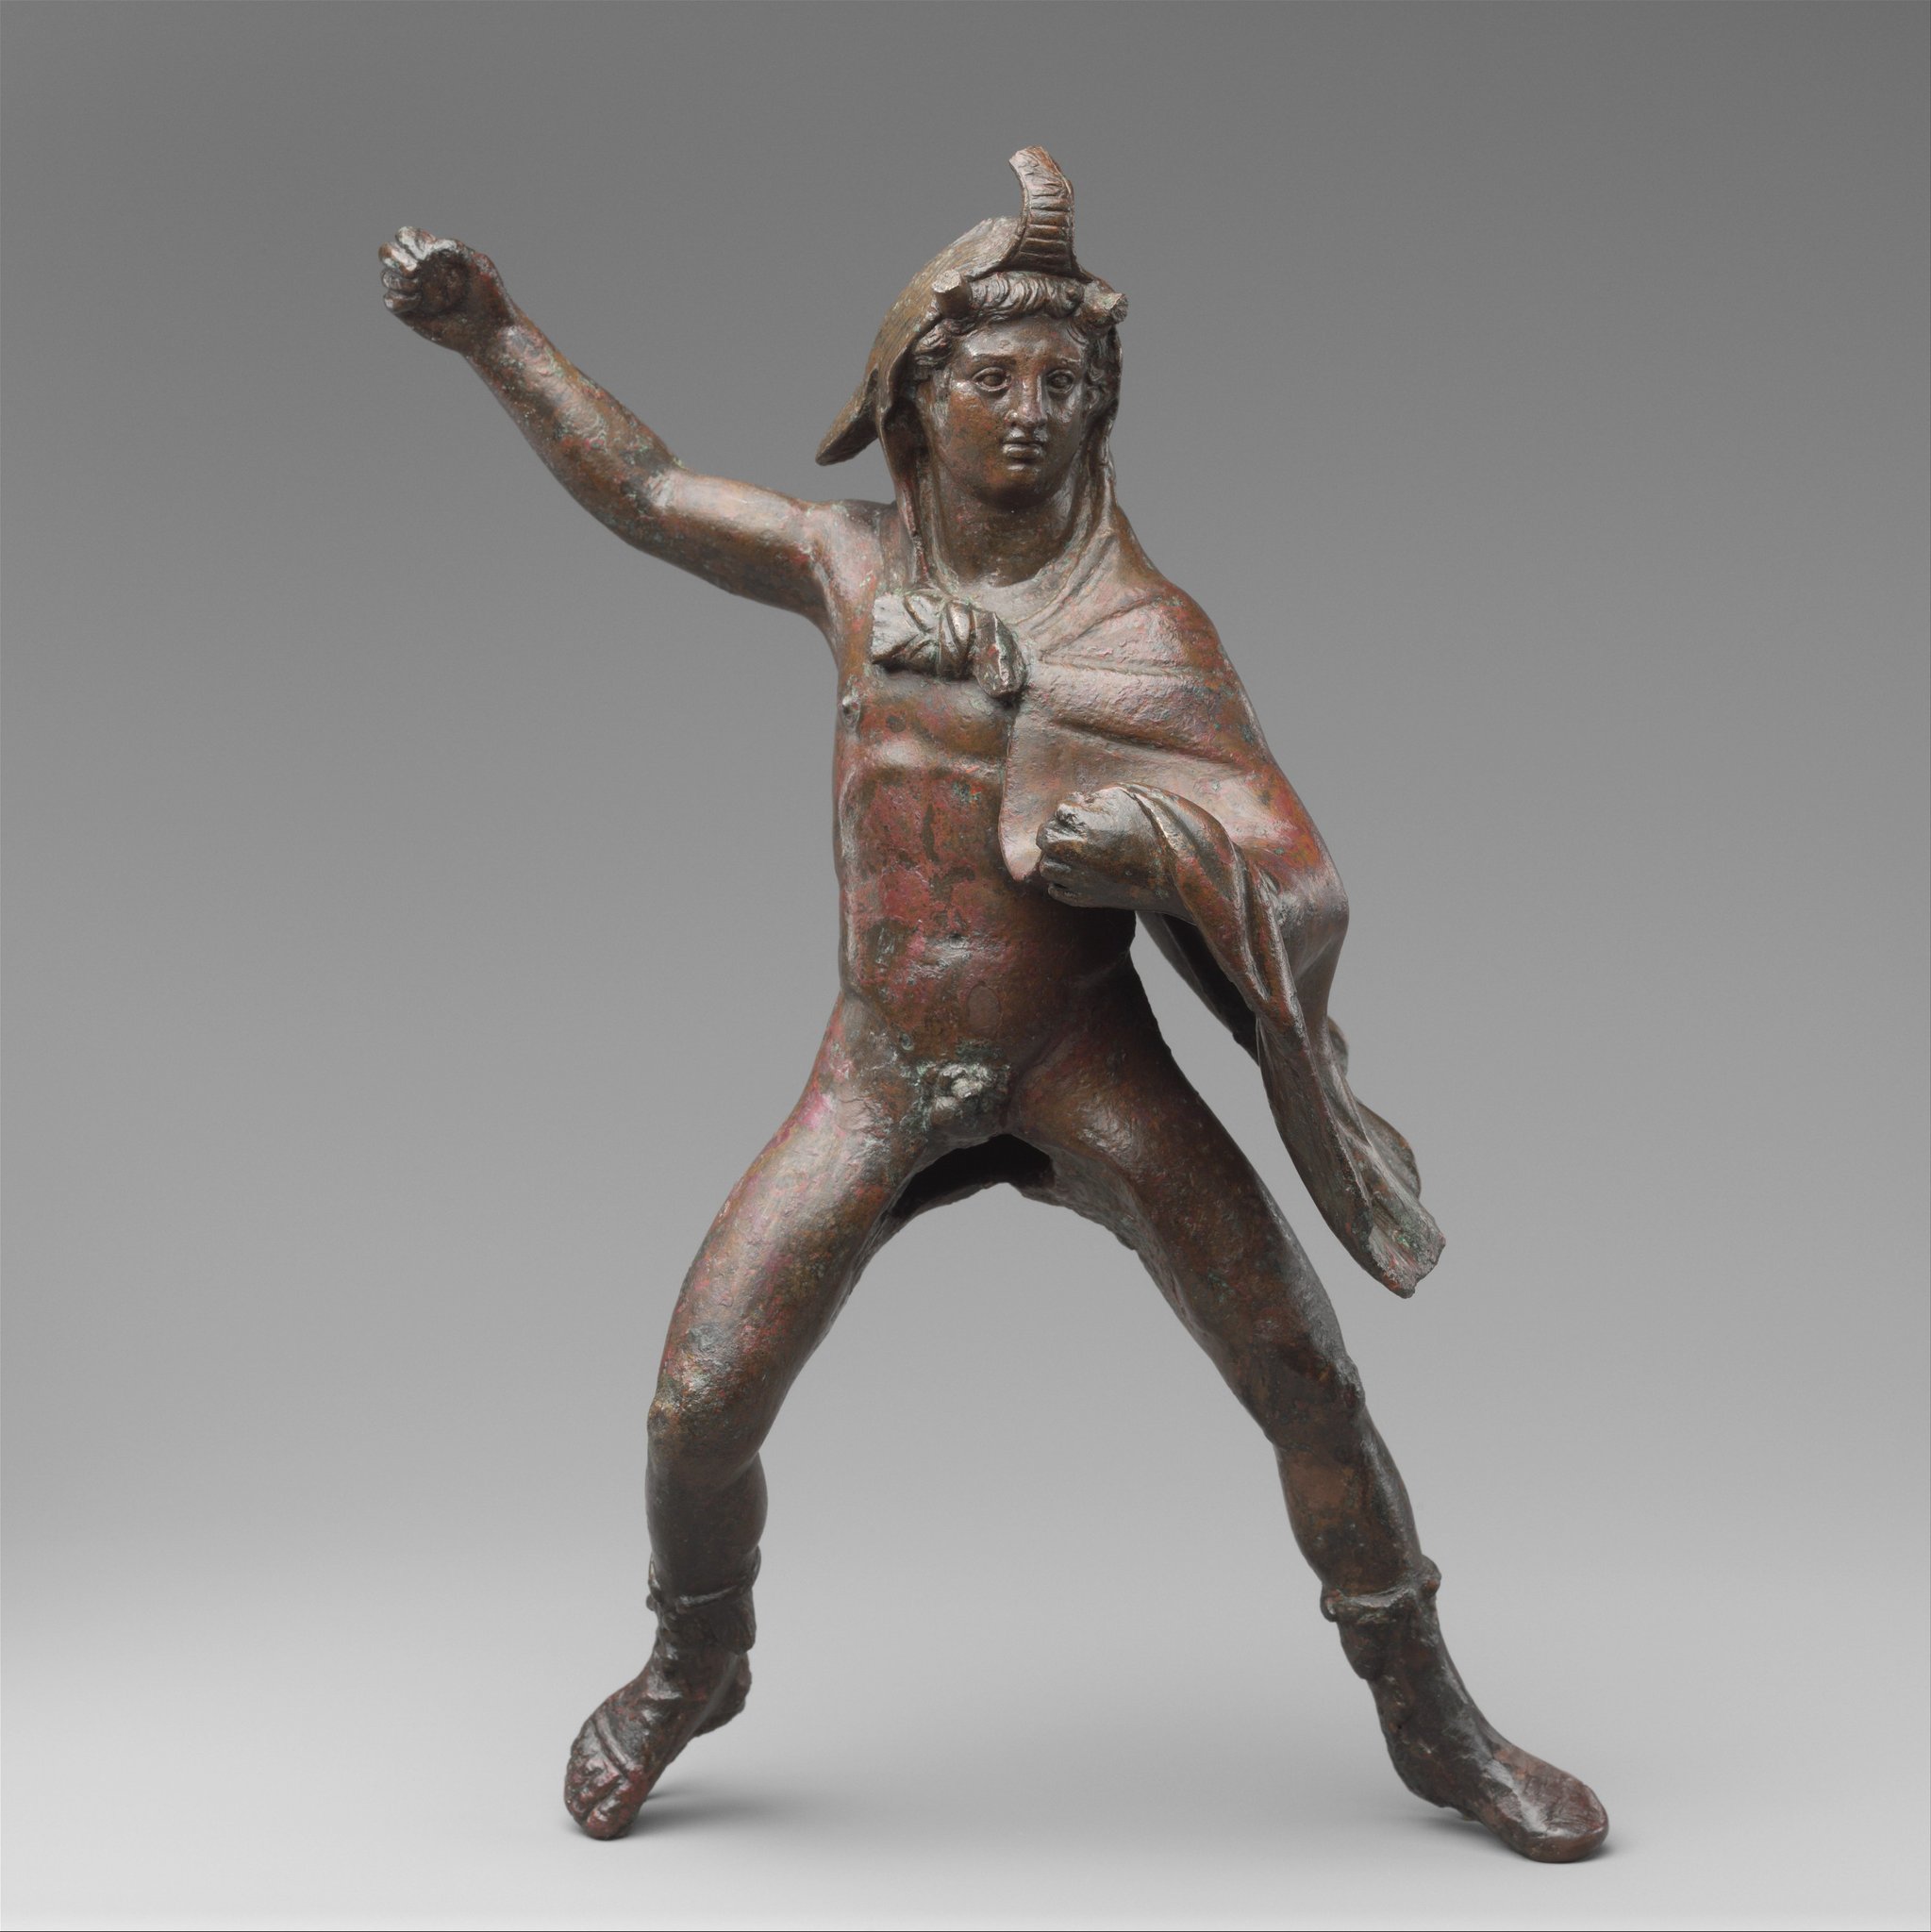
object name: statuette of a horse or elephant rider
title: Bronze statuette of a rider wearing an elephant skin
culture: greek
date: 300-201 BCE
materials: bronze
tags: male nudes